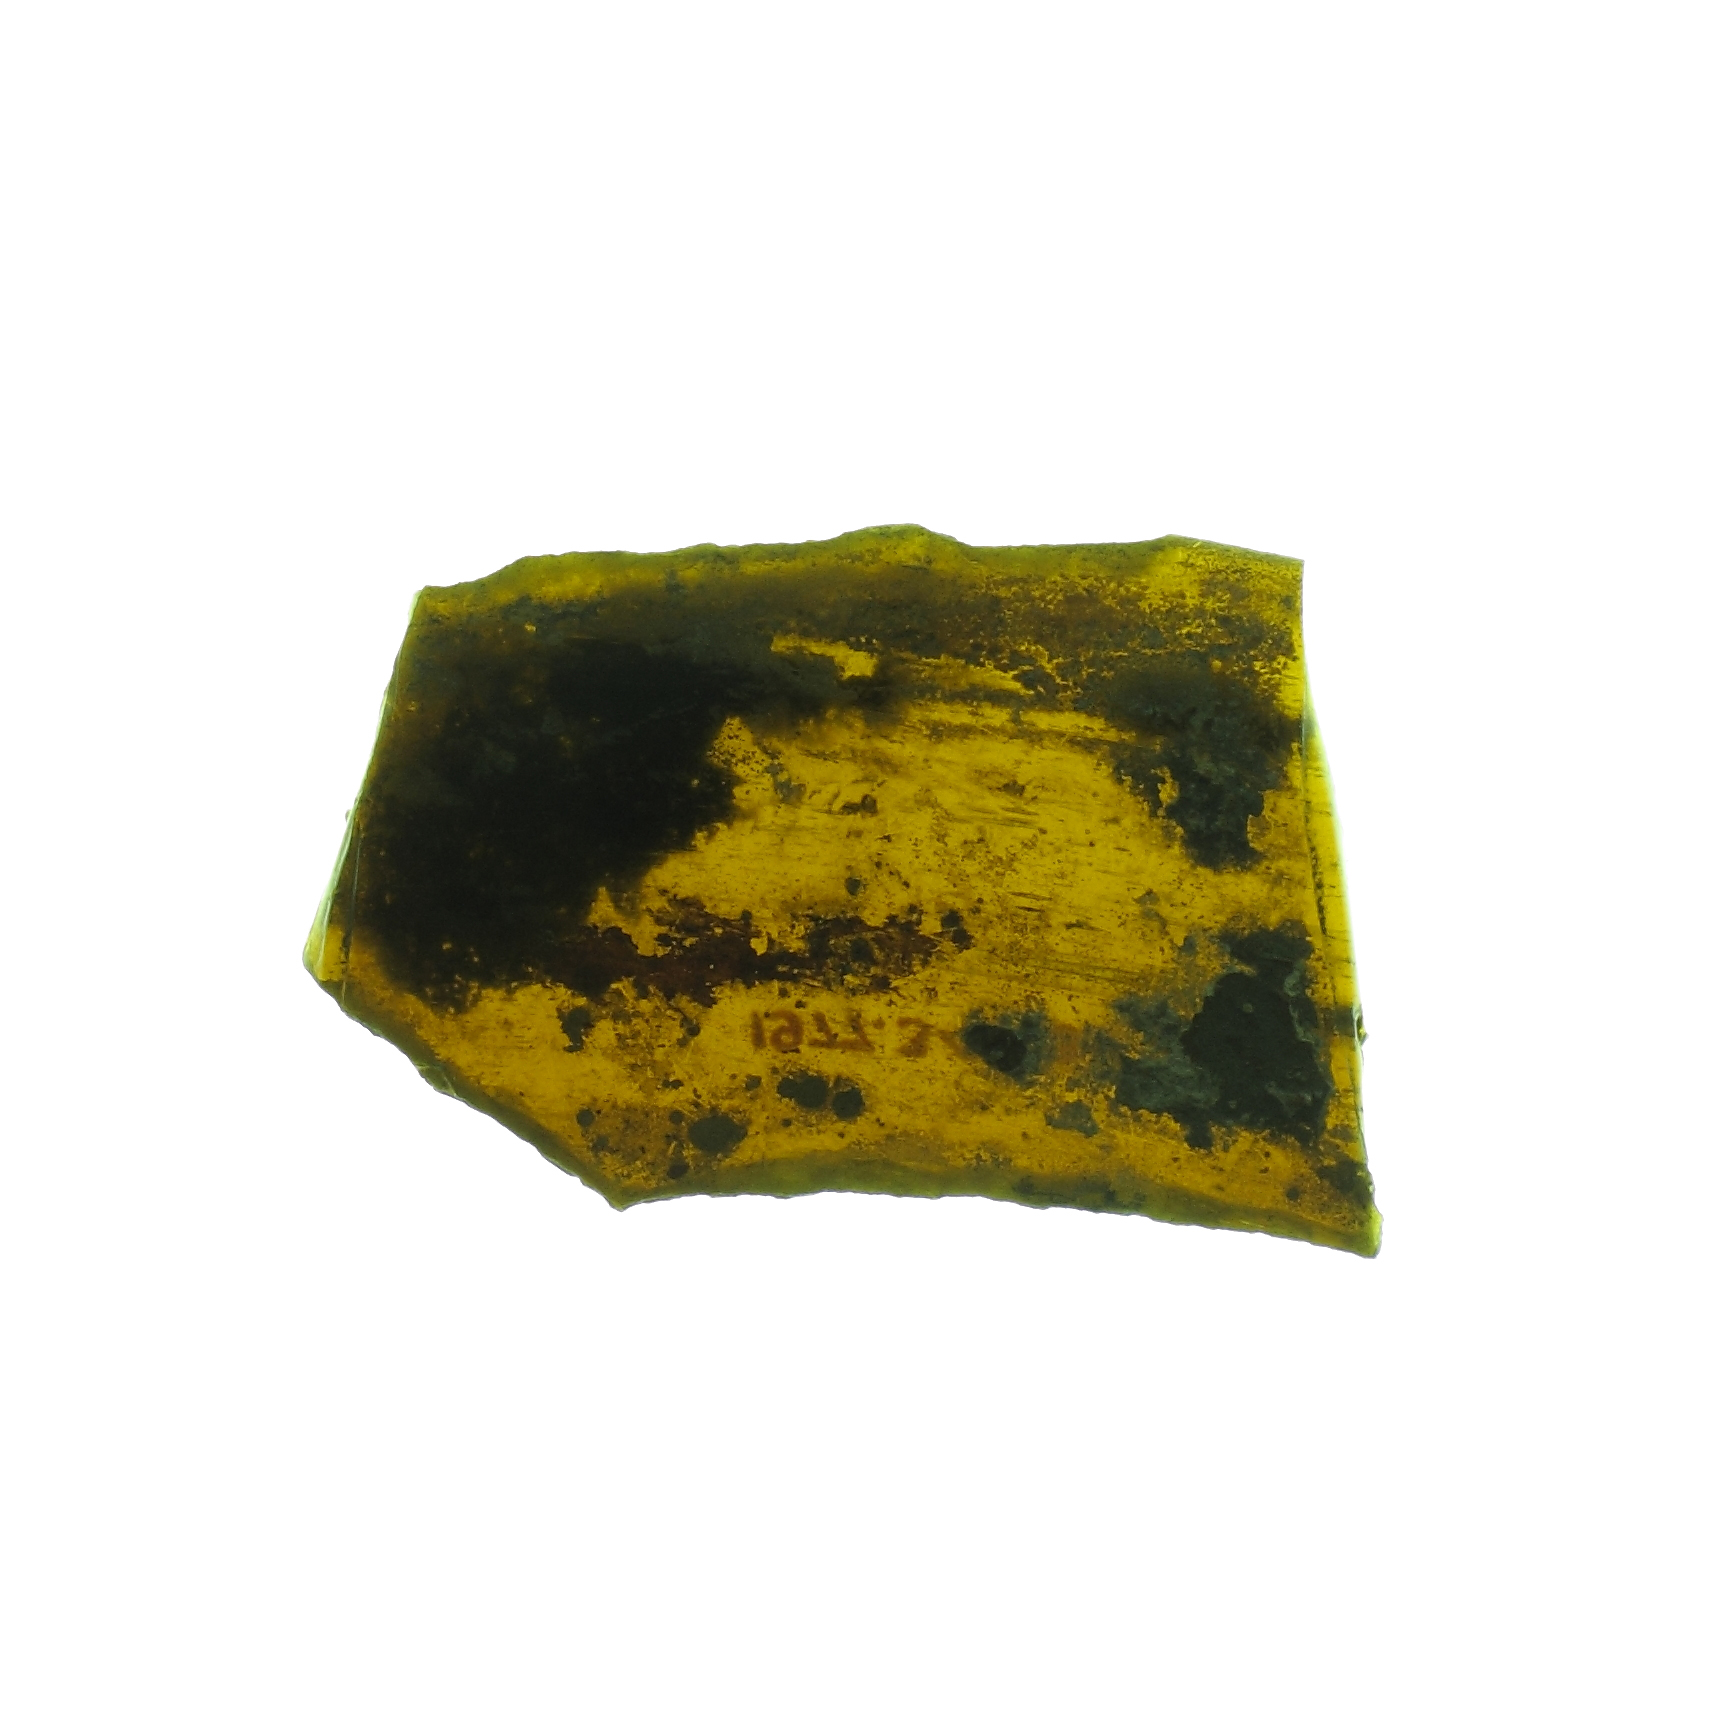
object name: fragment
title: Glass Fragment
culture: french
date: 1101-1400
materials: glass, metal, paint